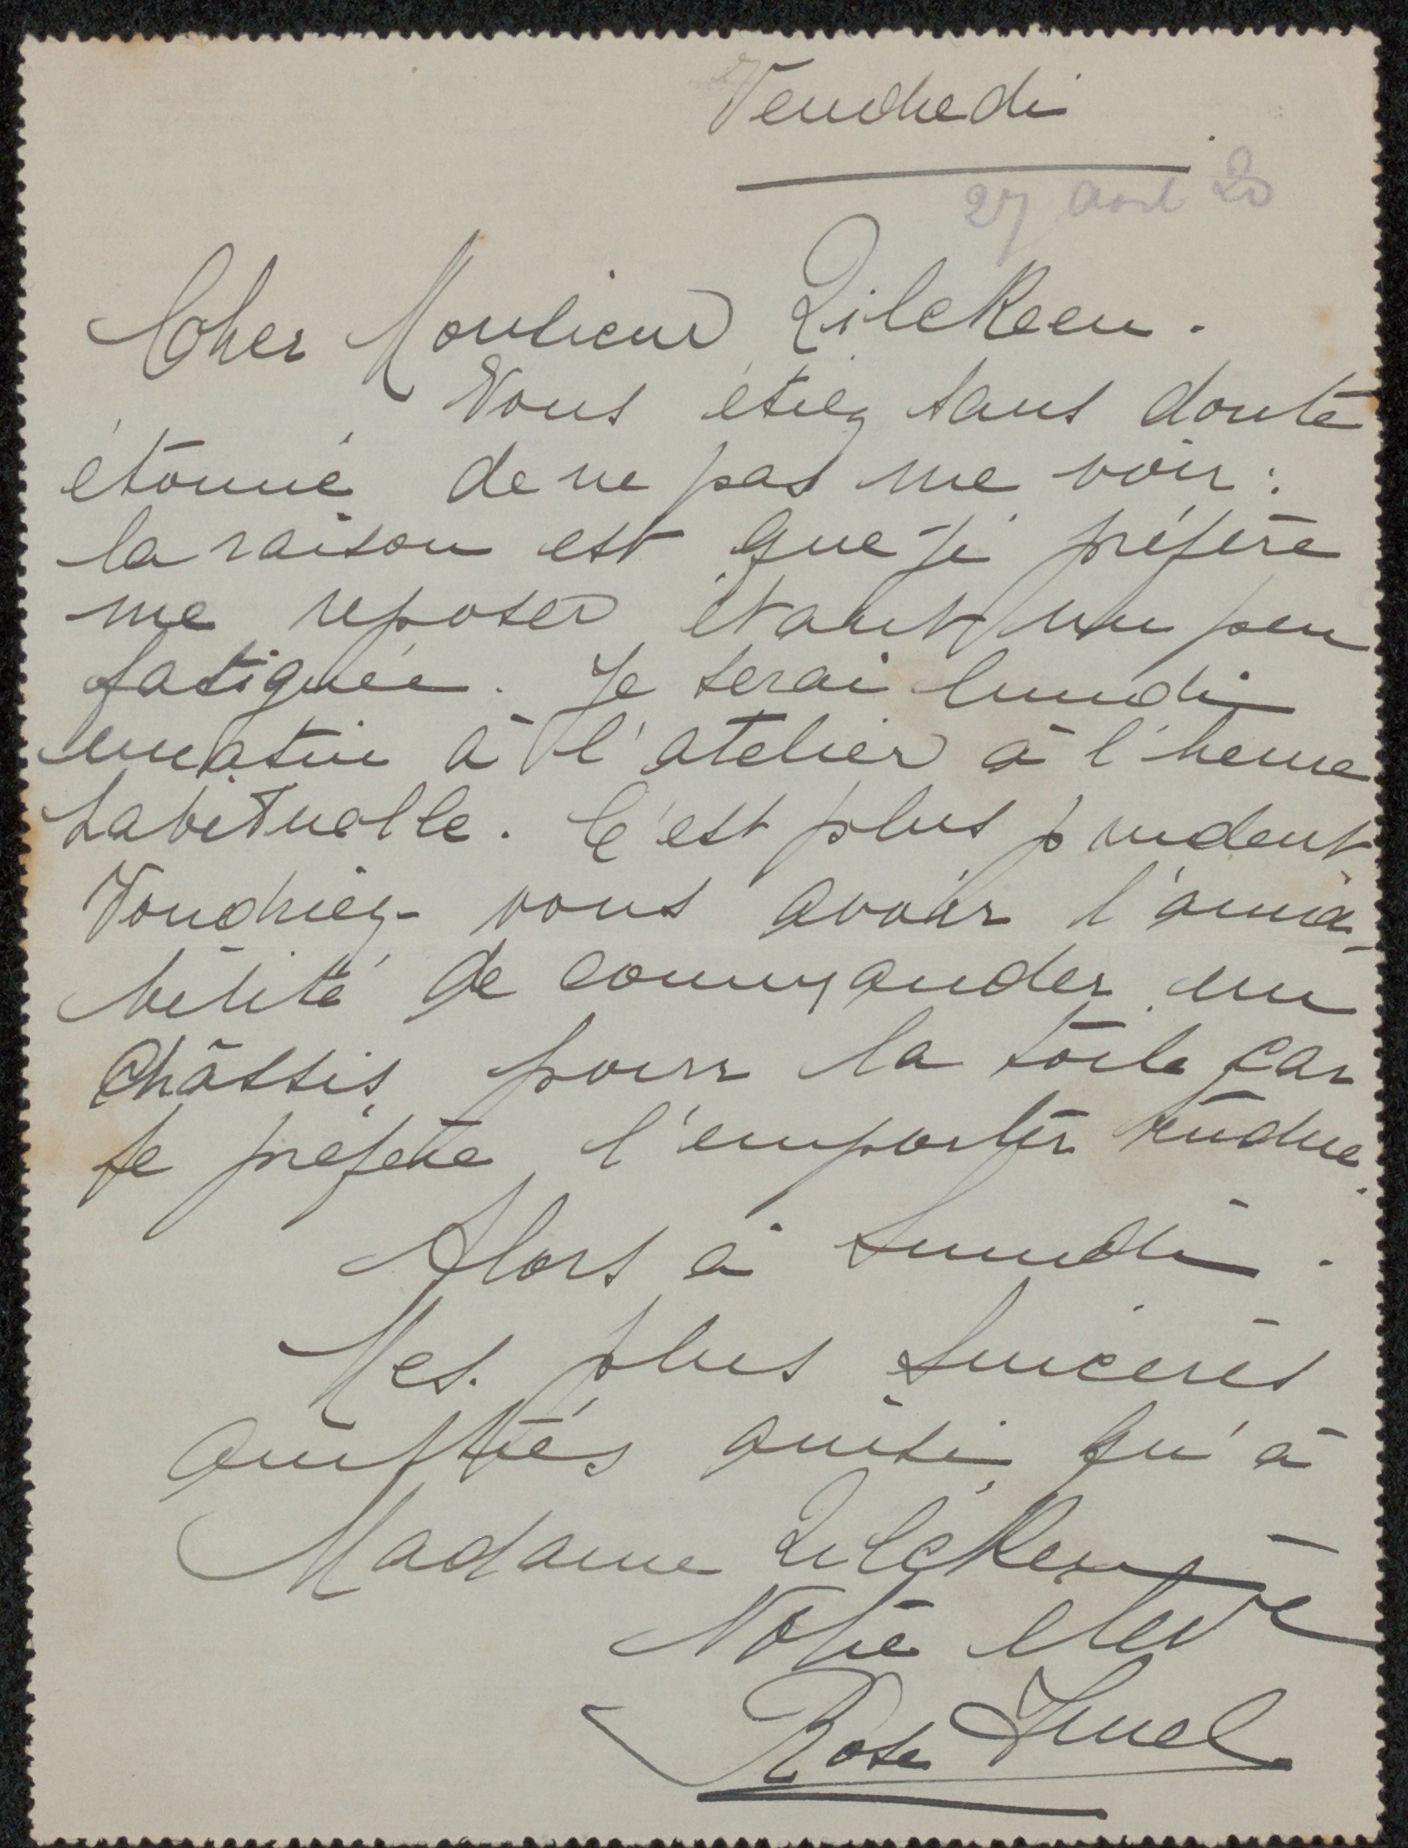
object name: letter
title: Brief aan Philip Zilcken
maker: rose imel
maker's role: draughtsman, painter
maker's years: 1901-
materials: ink, paper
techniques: pen, writing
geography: scheveningen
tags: the hague, painter, draughtsman, philip zilcken, workshop, studio of the artist (in general)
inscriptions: collector's mark: ‘RPK’